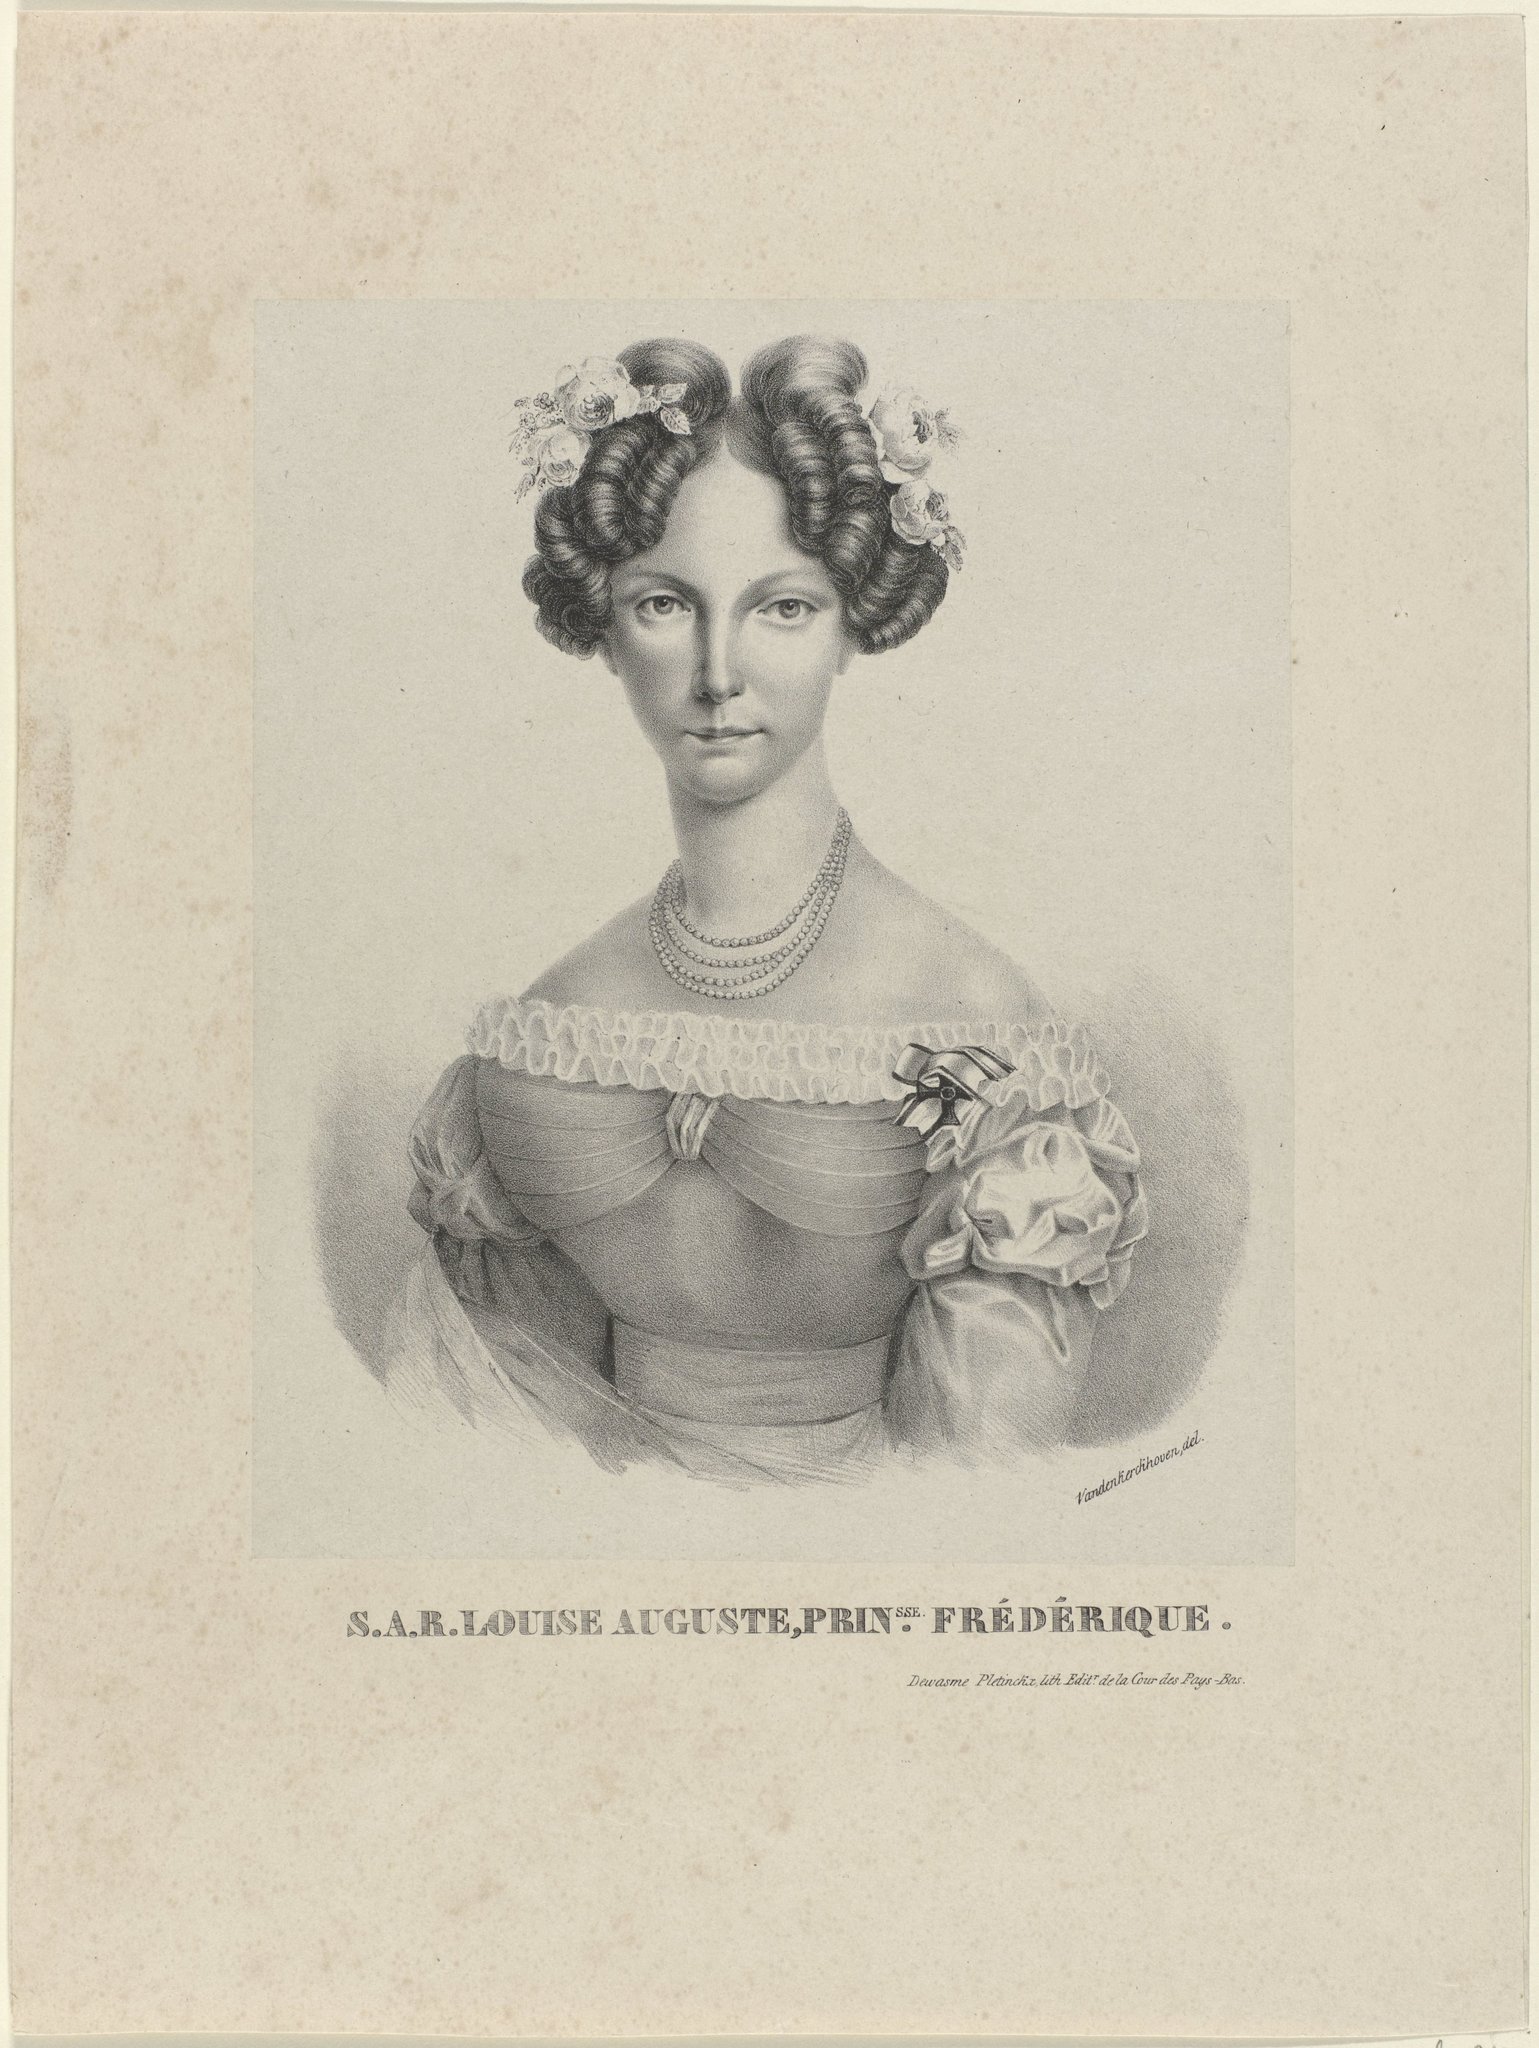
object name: print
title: Portret van Louise van Pruisen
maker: lith. de la cour des ps. bas à bruxelles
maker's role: printer, publisher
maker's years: 1797-1851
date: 1825-1851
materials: paper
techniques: lithograph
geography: brussels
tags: wassenaar, prinses, louise van pruisen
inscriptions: collector's mark: Lugt 963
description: Portret van Louise. In de ondermarge haar naam en titel.